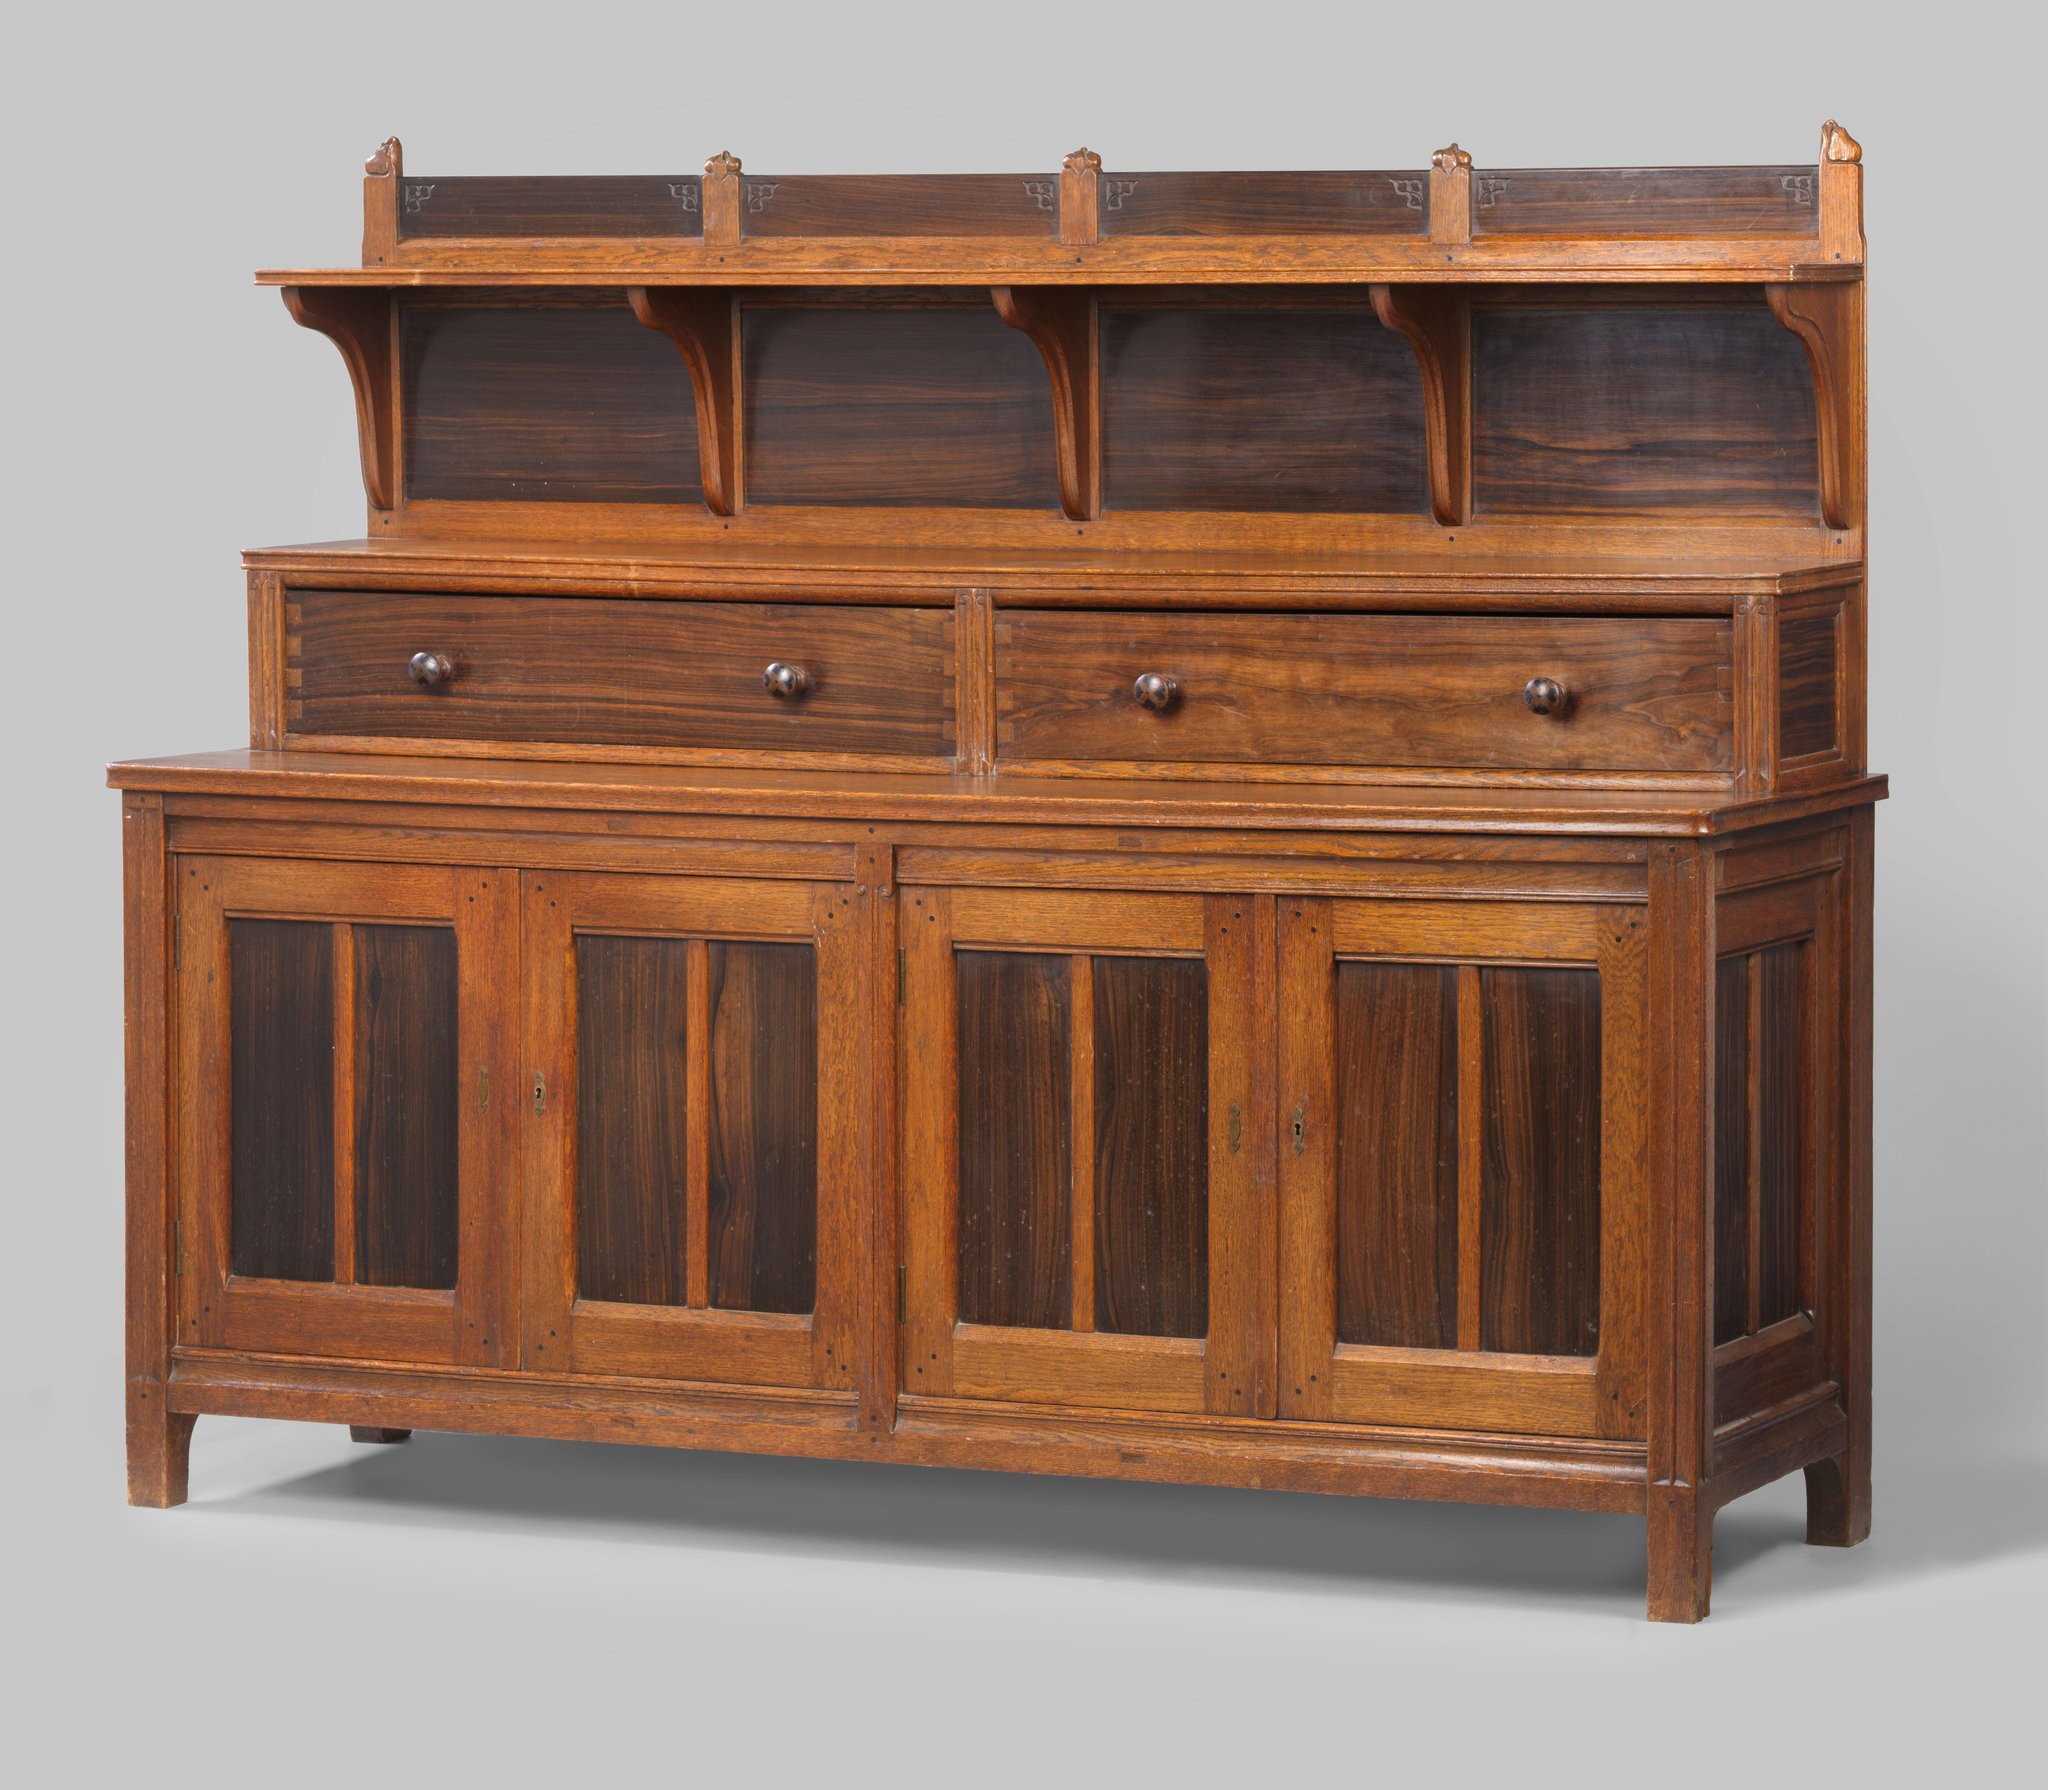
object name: case furniture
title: Buffet met terugwijkende bovenbouw waarin twee laden en een schap, versierd met snijwerk van vruchten en gestileerd bladwerk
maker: theo nieuwenhuis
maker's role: designer, draughtsman, print maker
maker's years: 1866-1951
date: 1915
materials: wood, textile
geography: amsterdam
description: Buffet van eike- en coromandelhout. De onderbouw is afgesloten door twee dubbele deuren. Deze deuren zijn door een middenstijl in twee panelen van coromandelhout verdeeld. De terugwijkende bovenbouw heeft twee hoge brede laden en een schap. Deze schap rust op vijf steunen, boven deze steunen zijn boven de plank korte stijlen bovenaan versierd met vruchten. De achterwand tussen deze stijlen draagt in de hoeken een versiering van gestileerde bladeren.